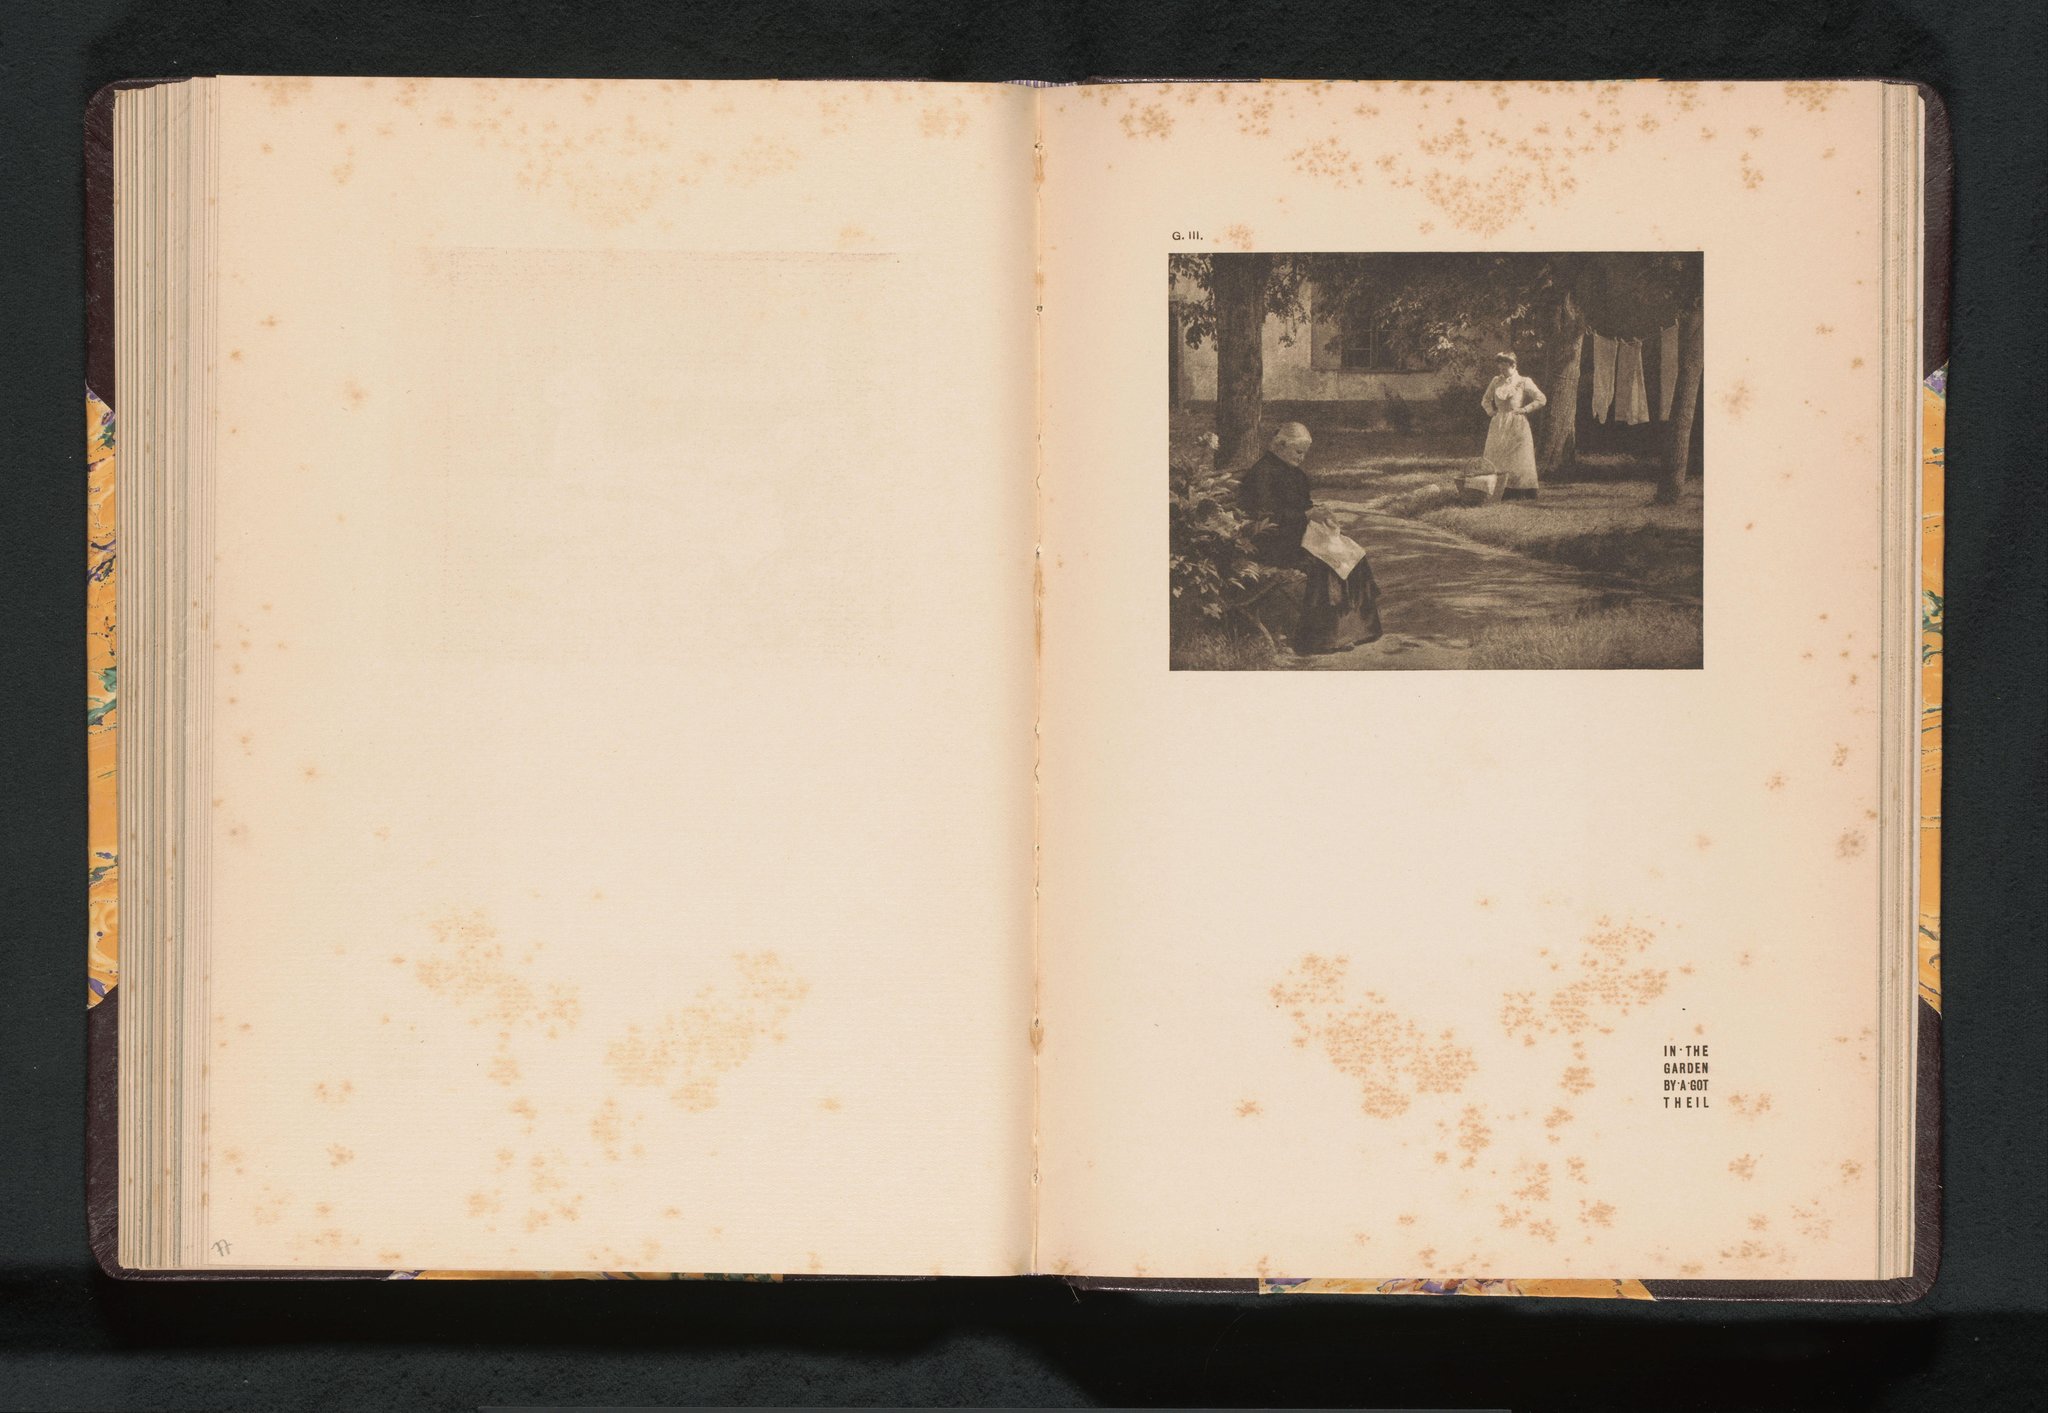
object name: photomechanical print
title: Twee vrouwen in de tuin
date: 1900-1905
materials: paper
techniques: two-color autotype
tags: adult woman, garden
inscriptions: inscription: ‘In the garden by A. Gottheil’, inscription: ‘G. III.’